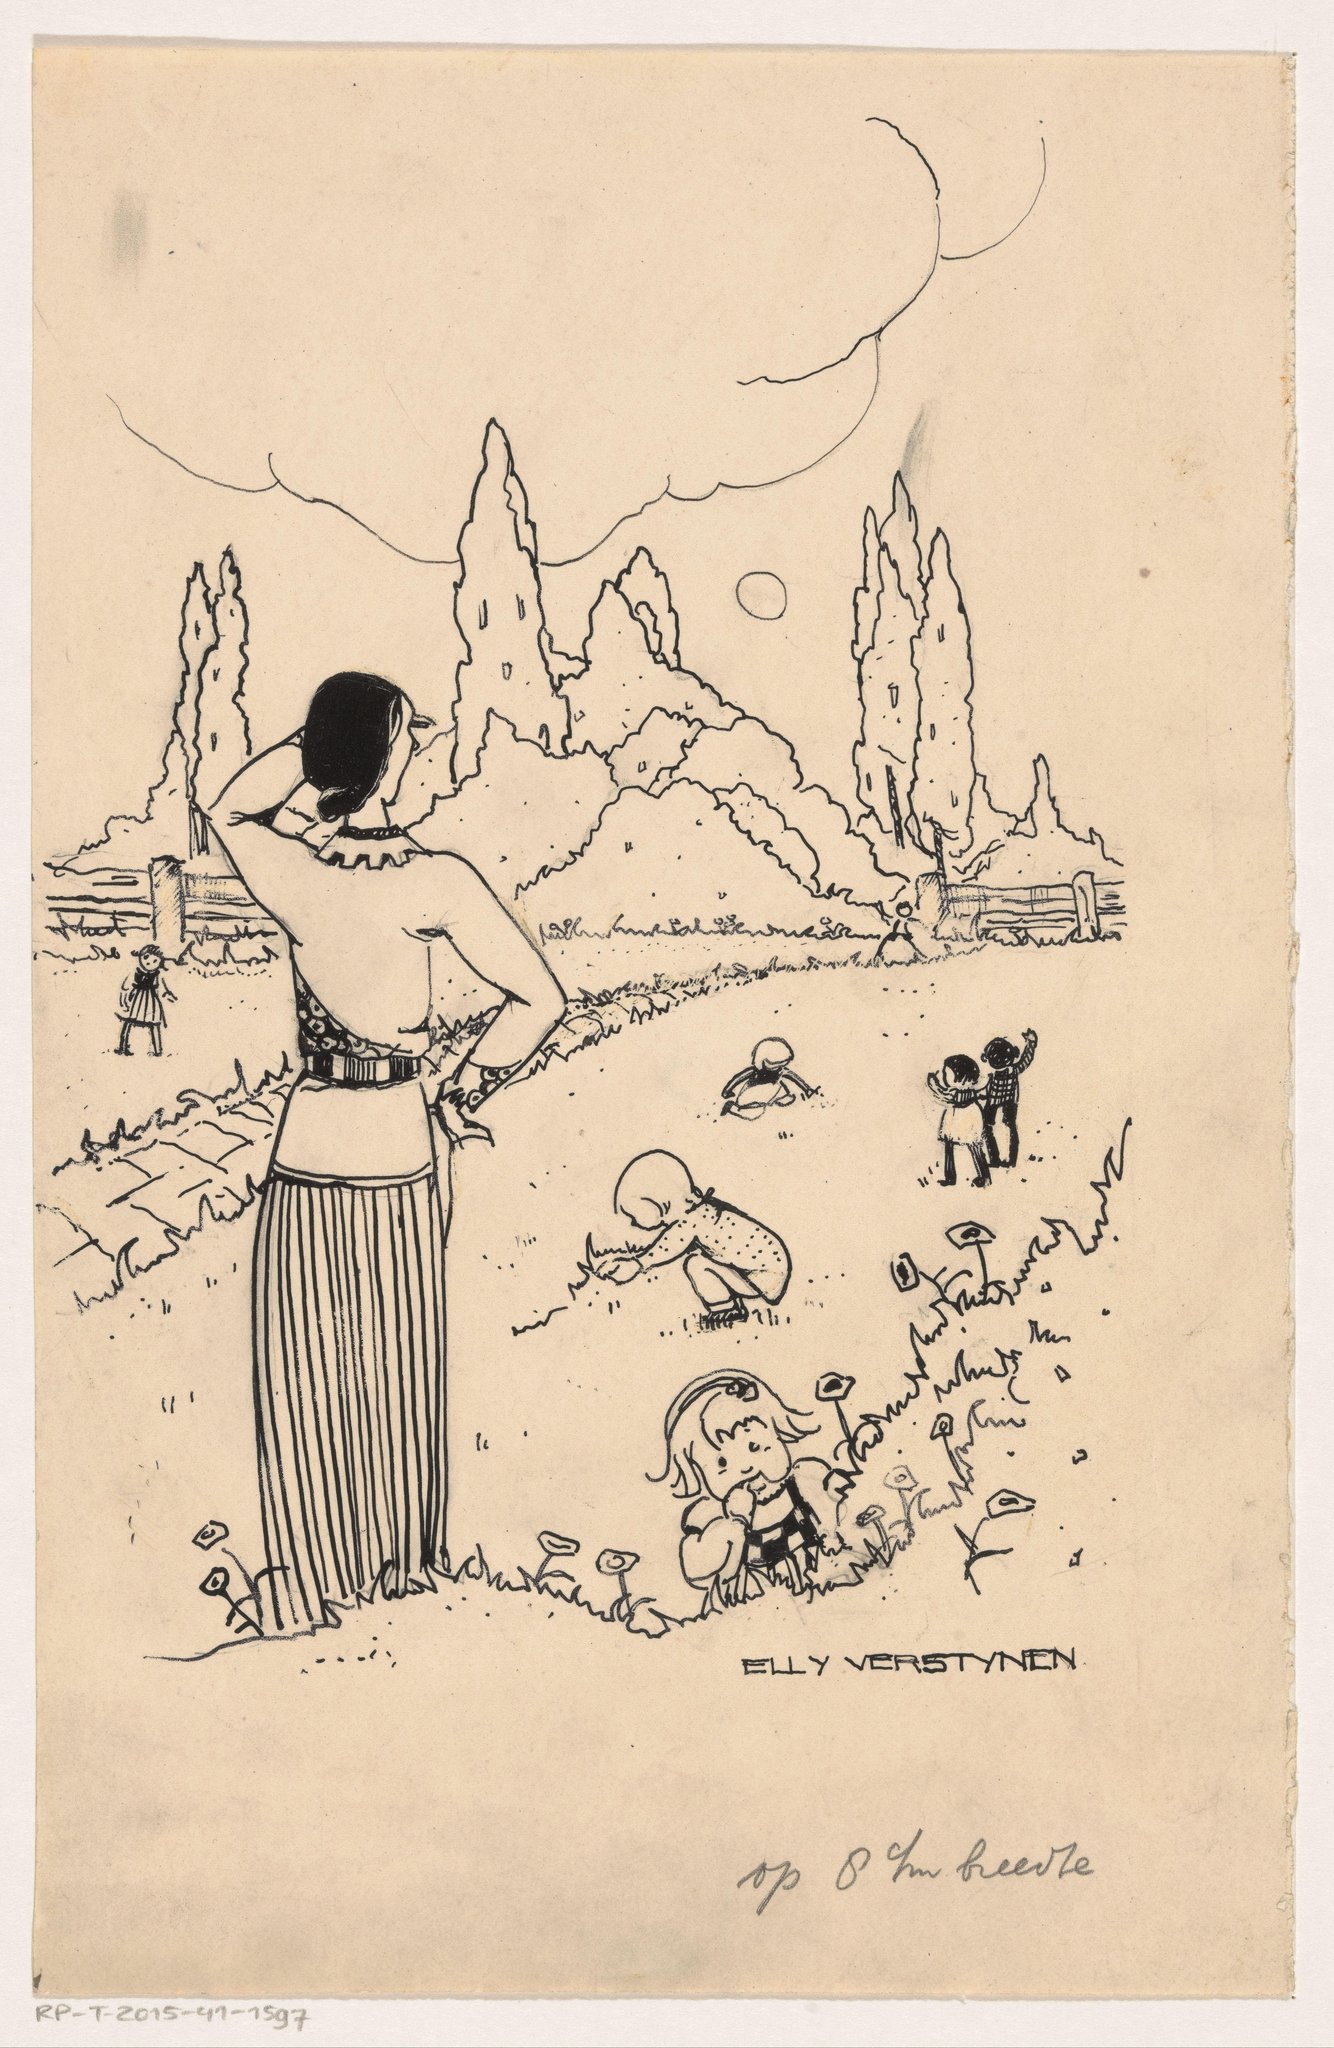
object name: drawing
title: Vrouw en spelende kinderen in een weide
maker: elly verstijnen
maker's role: draughtsman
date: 1900-1930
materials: ink, paper, pencil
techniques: pen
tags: meadow, pasture, child and nature (games and plays)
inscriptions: :, collector's mark: Lugt 2228, signature: ‘ELLY VERSTYNEN’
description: Een staande vrouw kijkt naar zes kinderen die in een weide spelen.